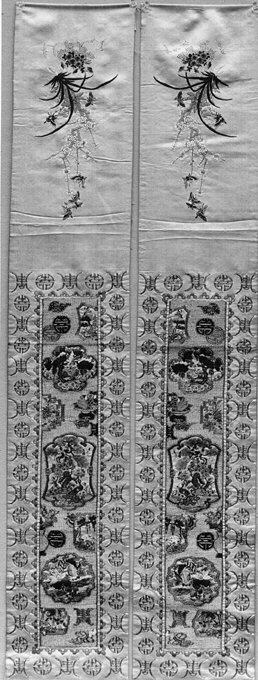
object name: sleeve band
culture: chinese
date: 1801-1900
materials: metal thread, silk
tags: flowers